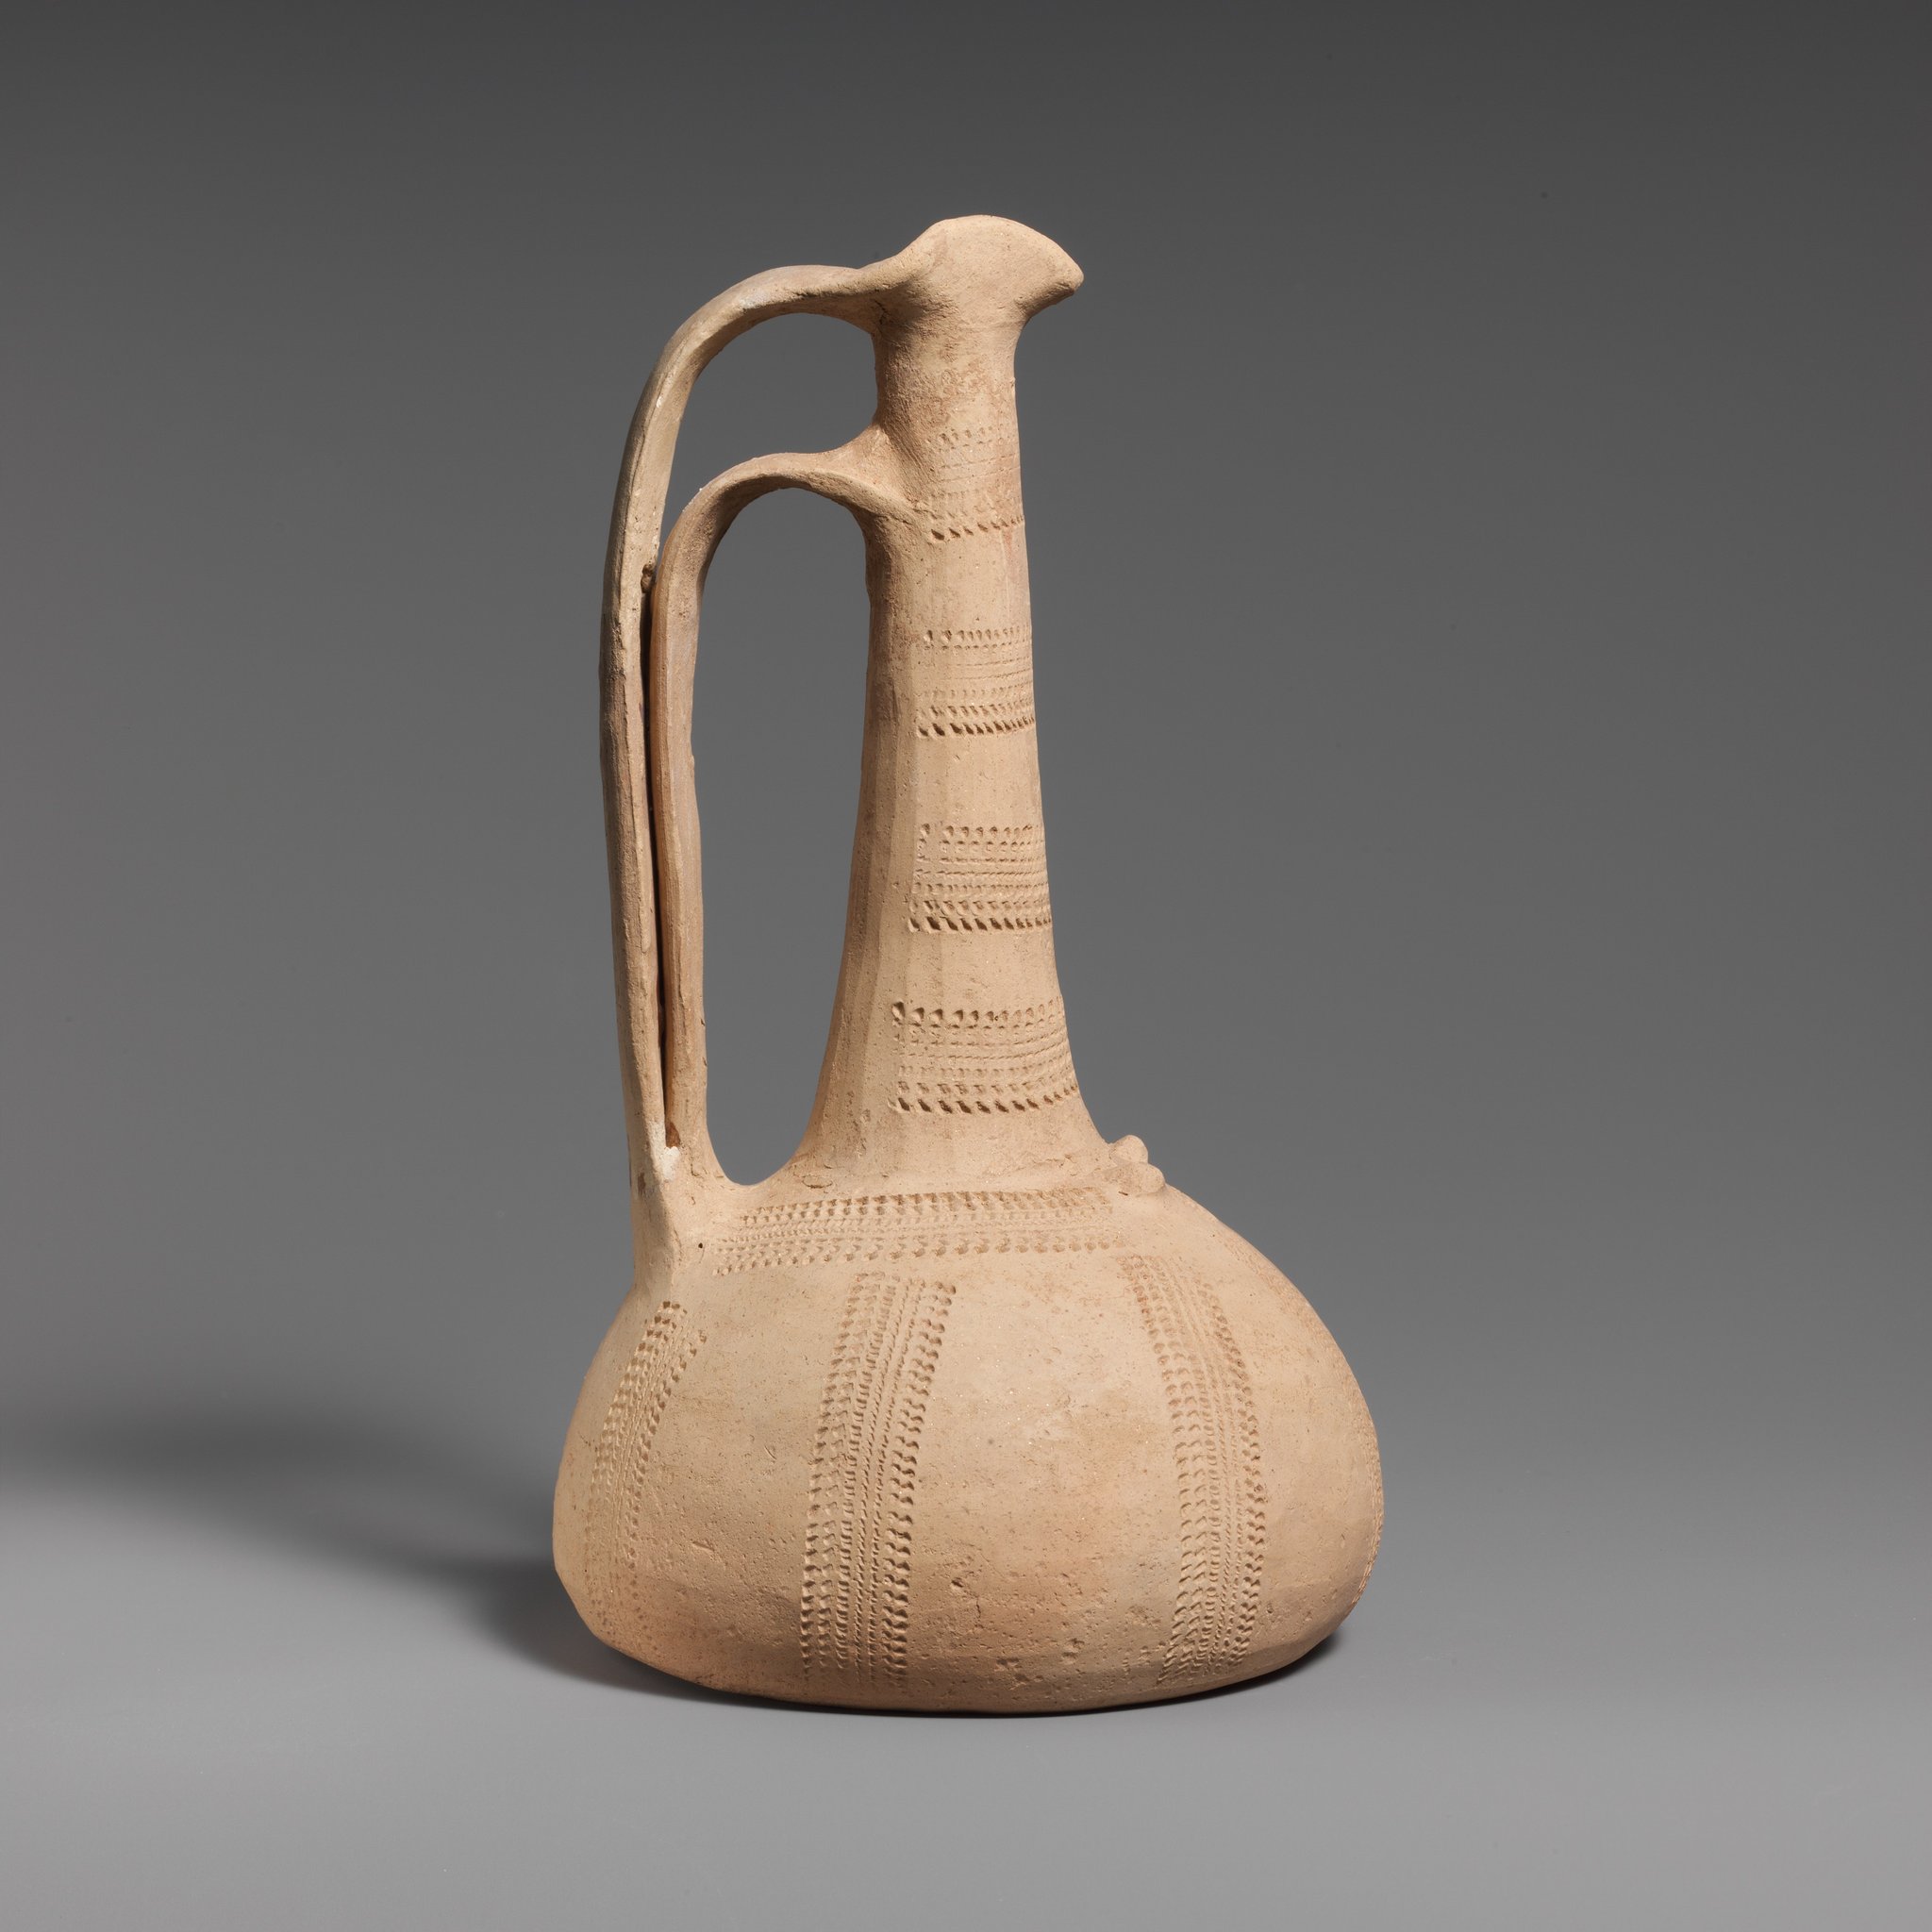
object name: lekythos oinochoe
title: Terracotta conical lekythos-oinochoe (combination oil flask and jug)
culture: greek, attic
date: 734-668 BCE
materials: terracotta